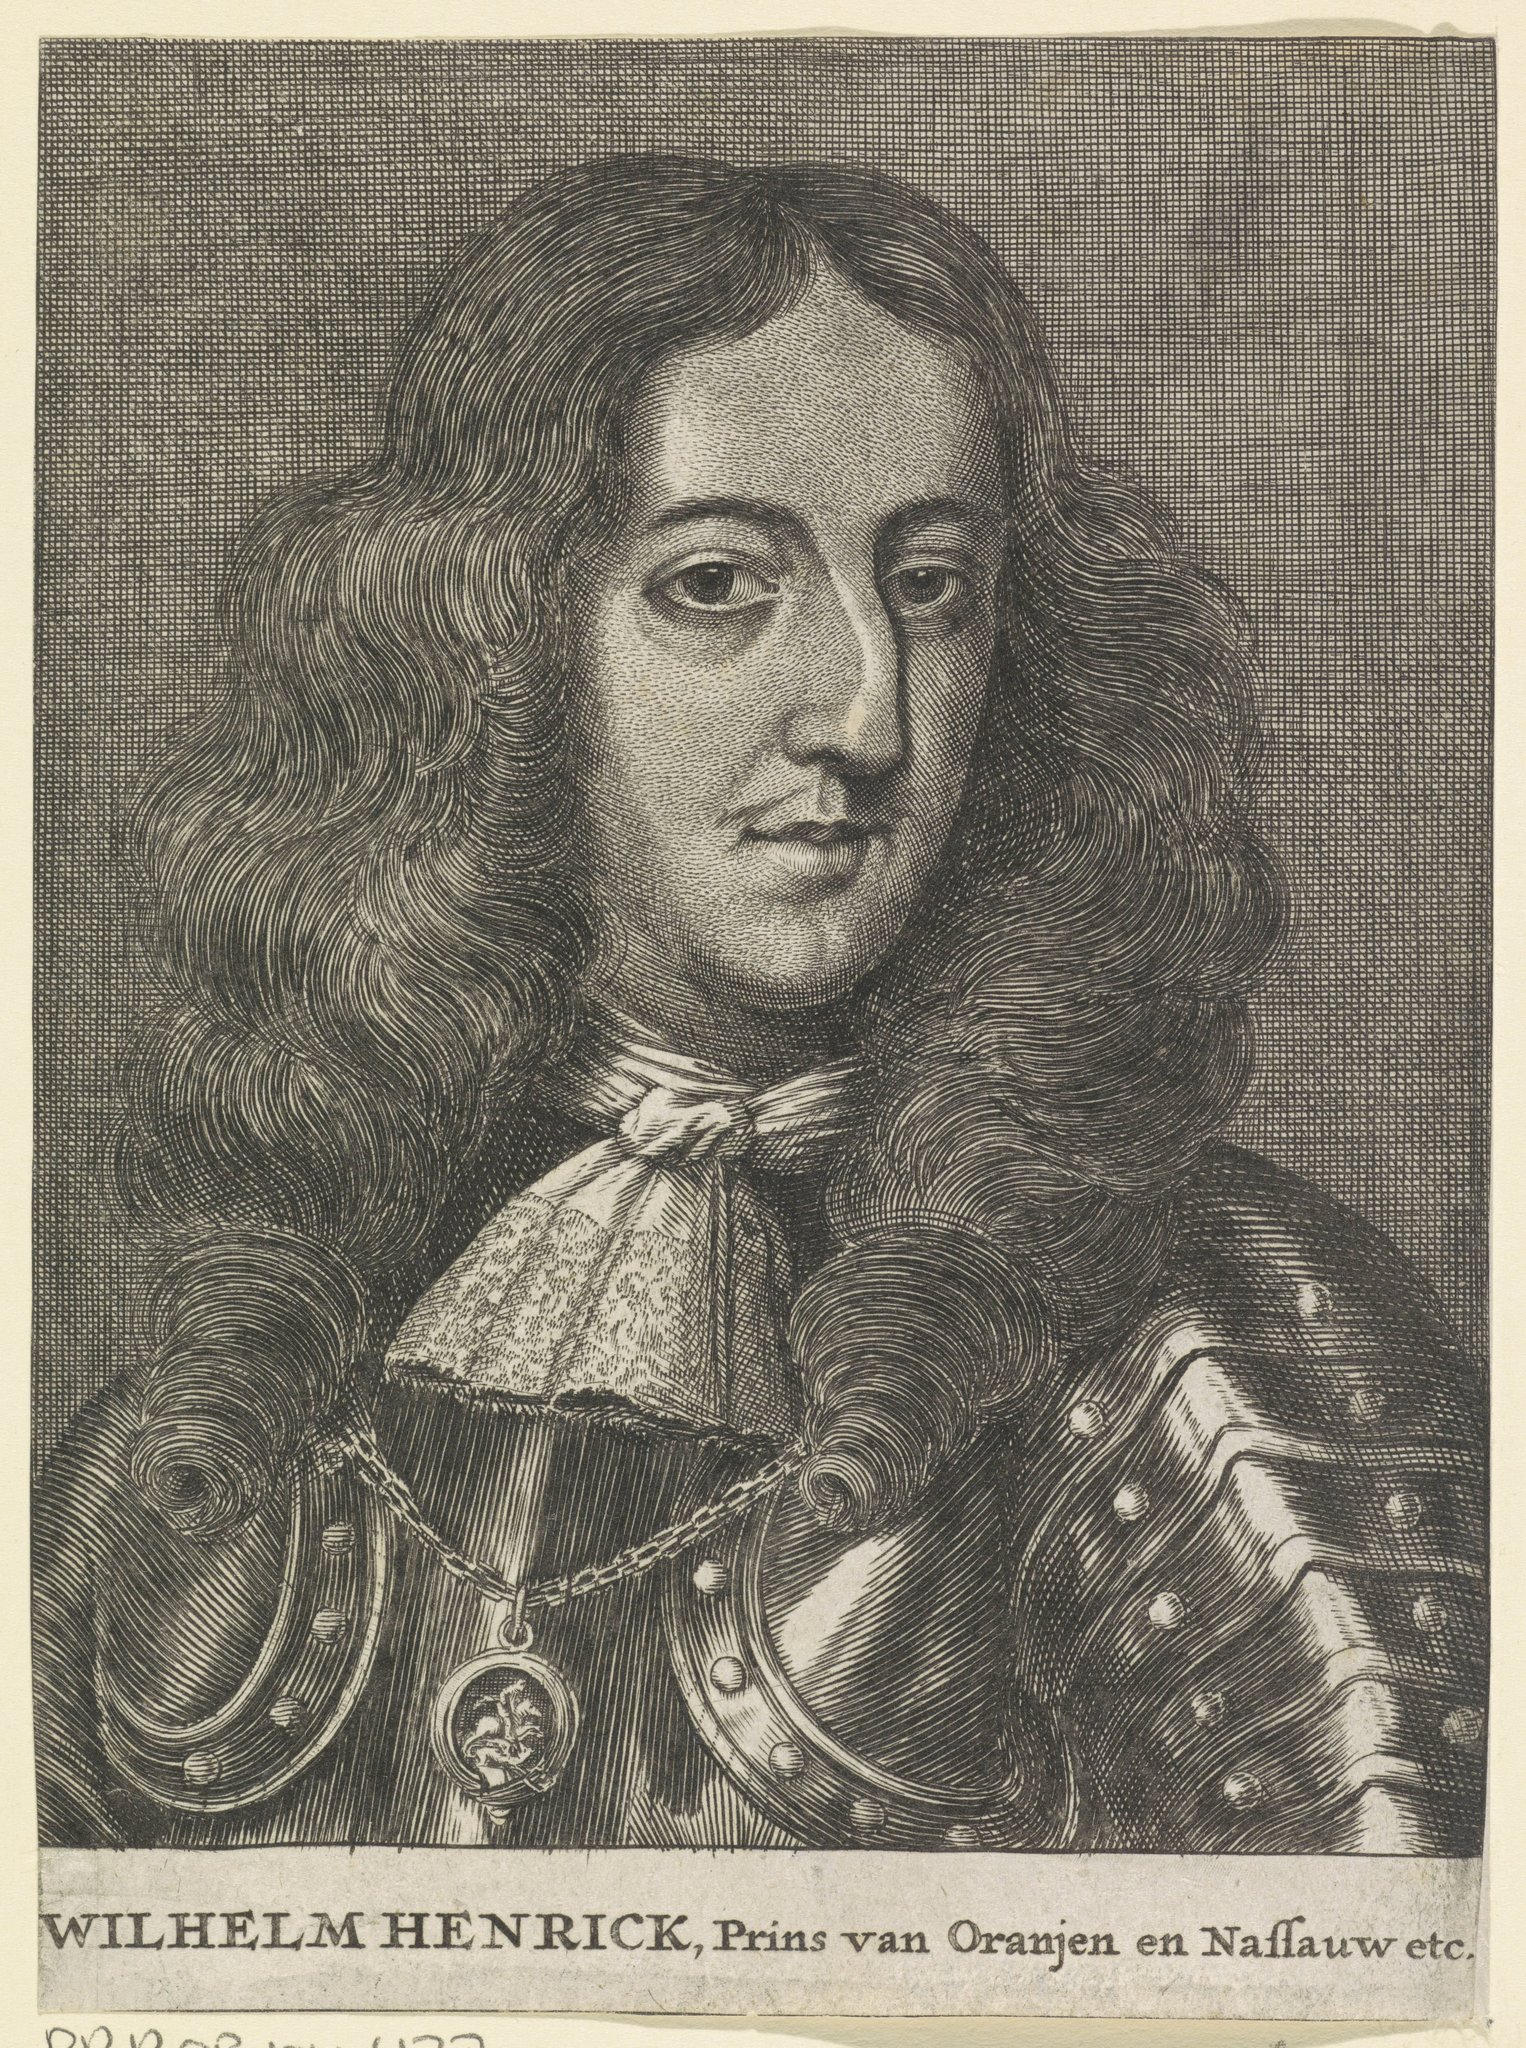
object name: print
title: Portret van Willem III, prins van Oranje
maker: Anonymous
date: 1670-1749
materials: paper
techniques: engraving, etching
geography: low countries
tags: william iii (prince of orange and king of england, scotland, and ireland), knighthood order (garter) - insignia of a knighthood order, e.g.: badge, chain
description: De hier vermelde titel verwijst naar de hoogst verkregen titel van de geportretteerde, niet per se naar de titel die de geportretteerde op deze voorstelling draagt.